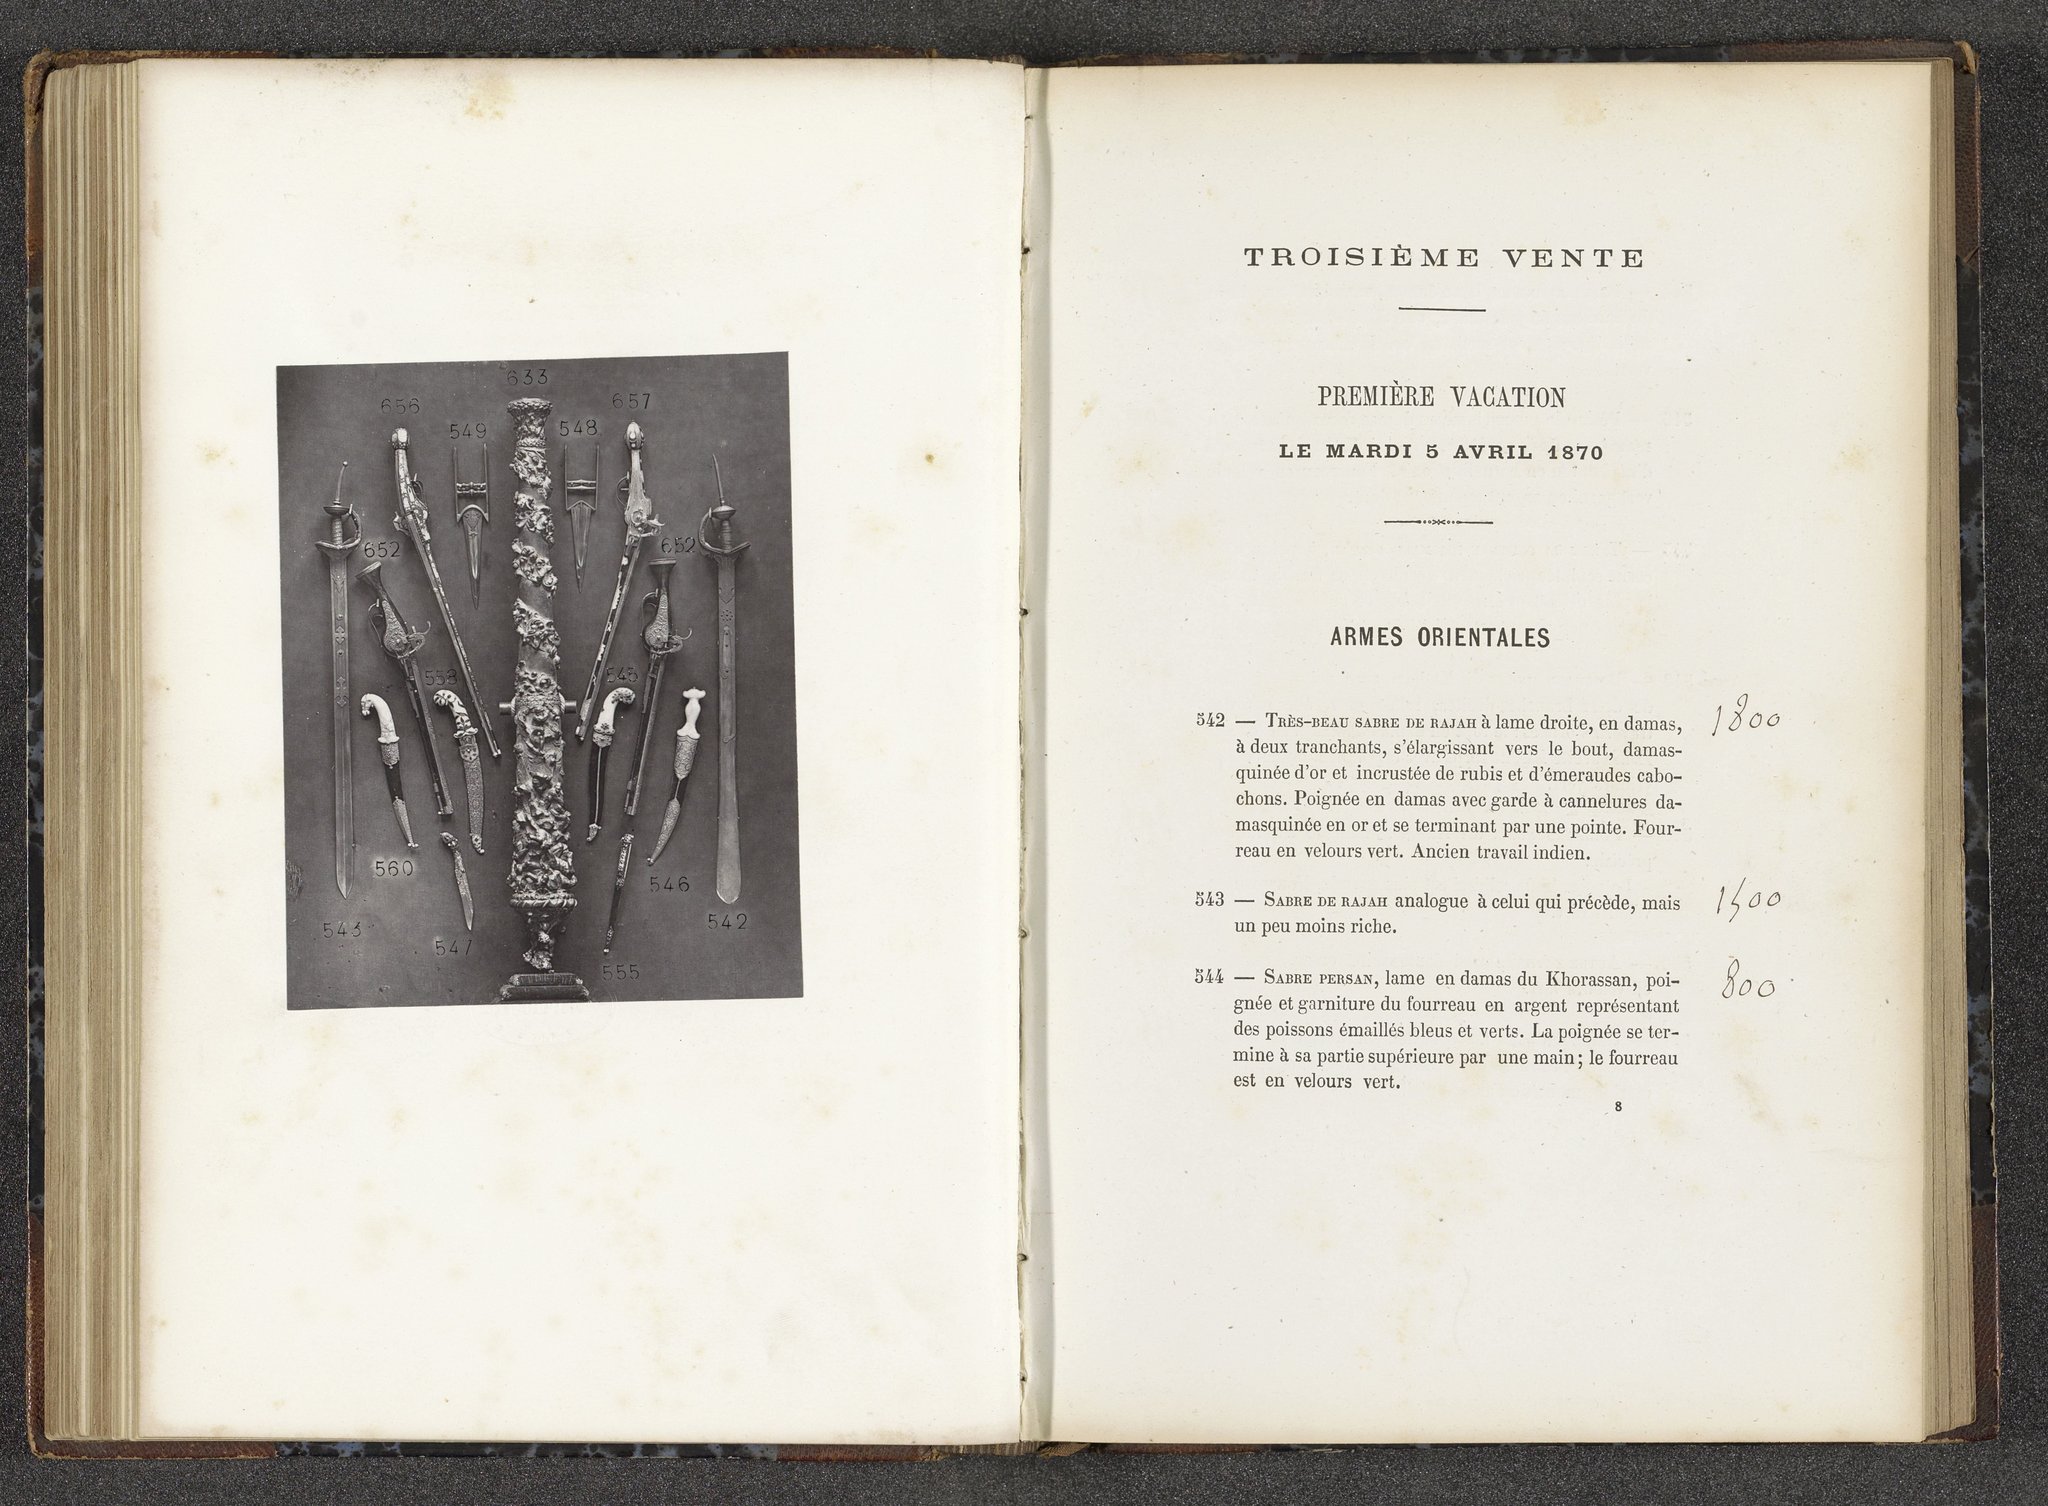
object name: photomechanical print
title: Steekwapens uit Azië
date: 1870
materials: paper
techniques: woodburytype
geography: paris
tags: hacking and thrusting weapons: dagger, hacking and thrusting weapons: sword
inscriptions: name: ‘De Goupil & Cie Imp. Photoglytique Paris’, number: ‘543 560 547 553 652 656 549 633 548 657 652 545 546 555 542’